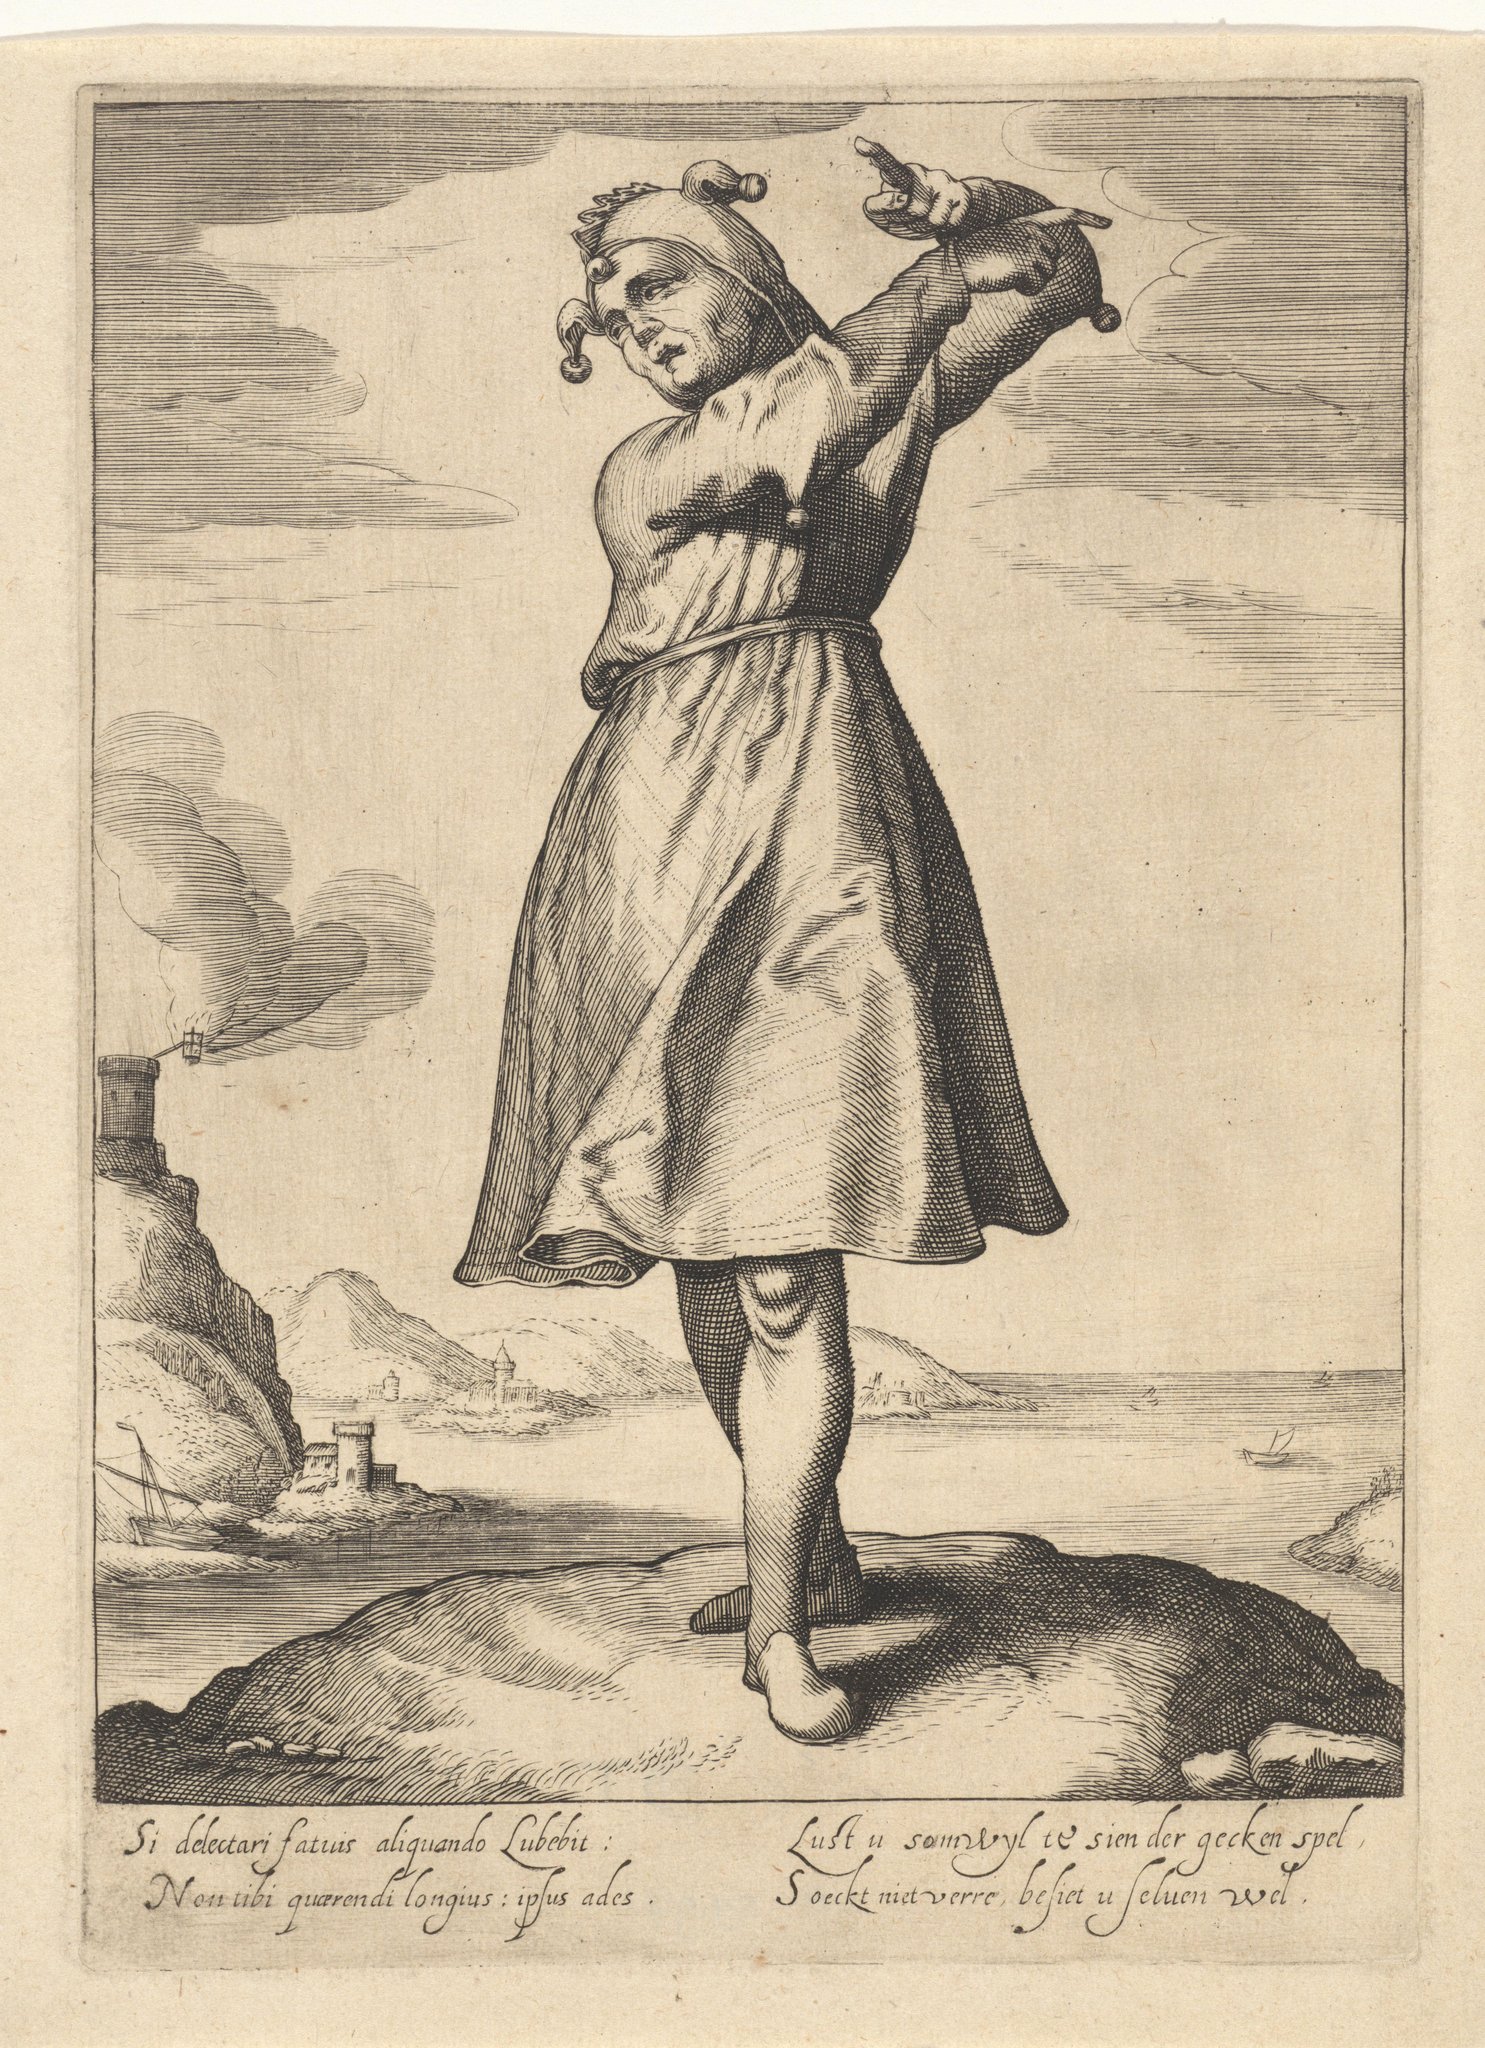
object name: print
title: Man met een narrenkap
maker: andries jacobsz. stock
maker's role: print maker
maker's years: 1572-1648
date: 1614-1648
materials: paper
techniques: engraving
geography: the hague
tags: landscapes in the temperate zone, fool's cap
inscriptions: collector's mark: Lugt 2228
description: Een man met een narrenkap op het hoofd staat in een kustlandschap en wijst met de ene hand in de verte en met de andere hand op de beschouwer. Onderaan in de marge een verklarende tekst in het Latijn en het Nederlands: Als de beschouwer graag gekkenspel ziet, dan kan hij beter niet ver zoeken. Hij wordt aangemoedigd om zichzelf eens goed te bekijken.